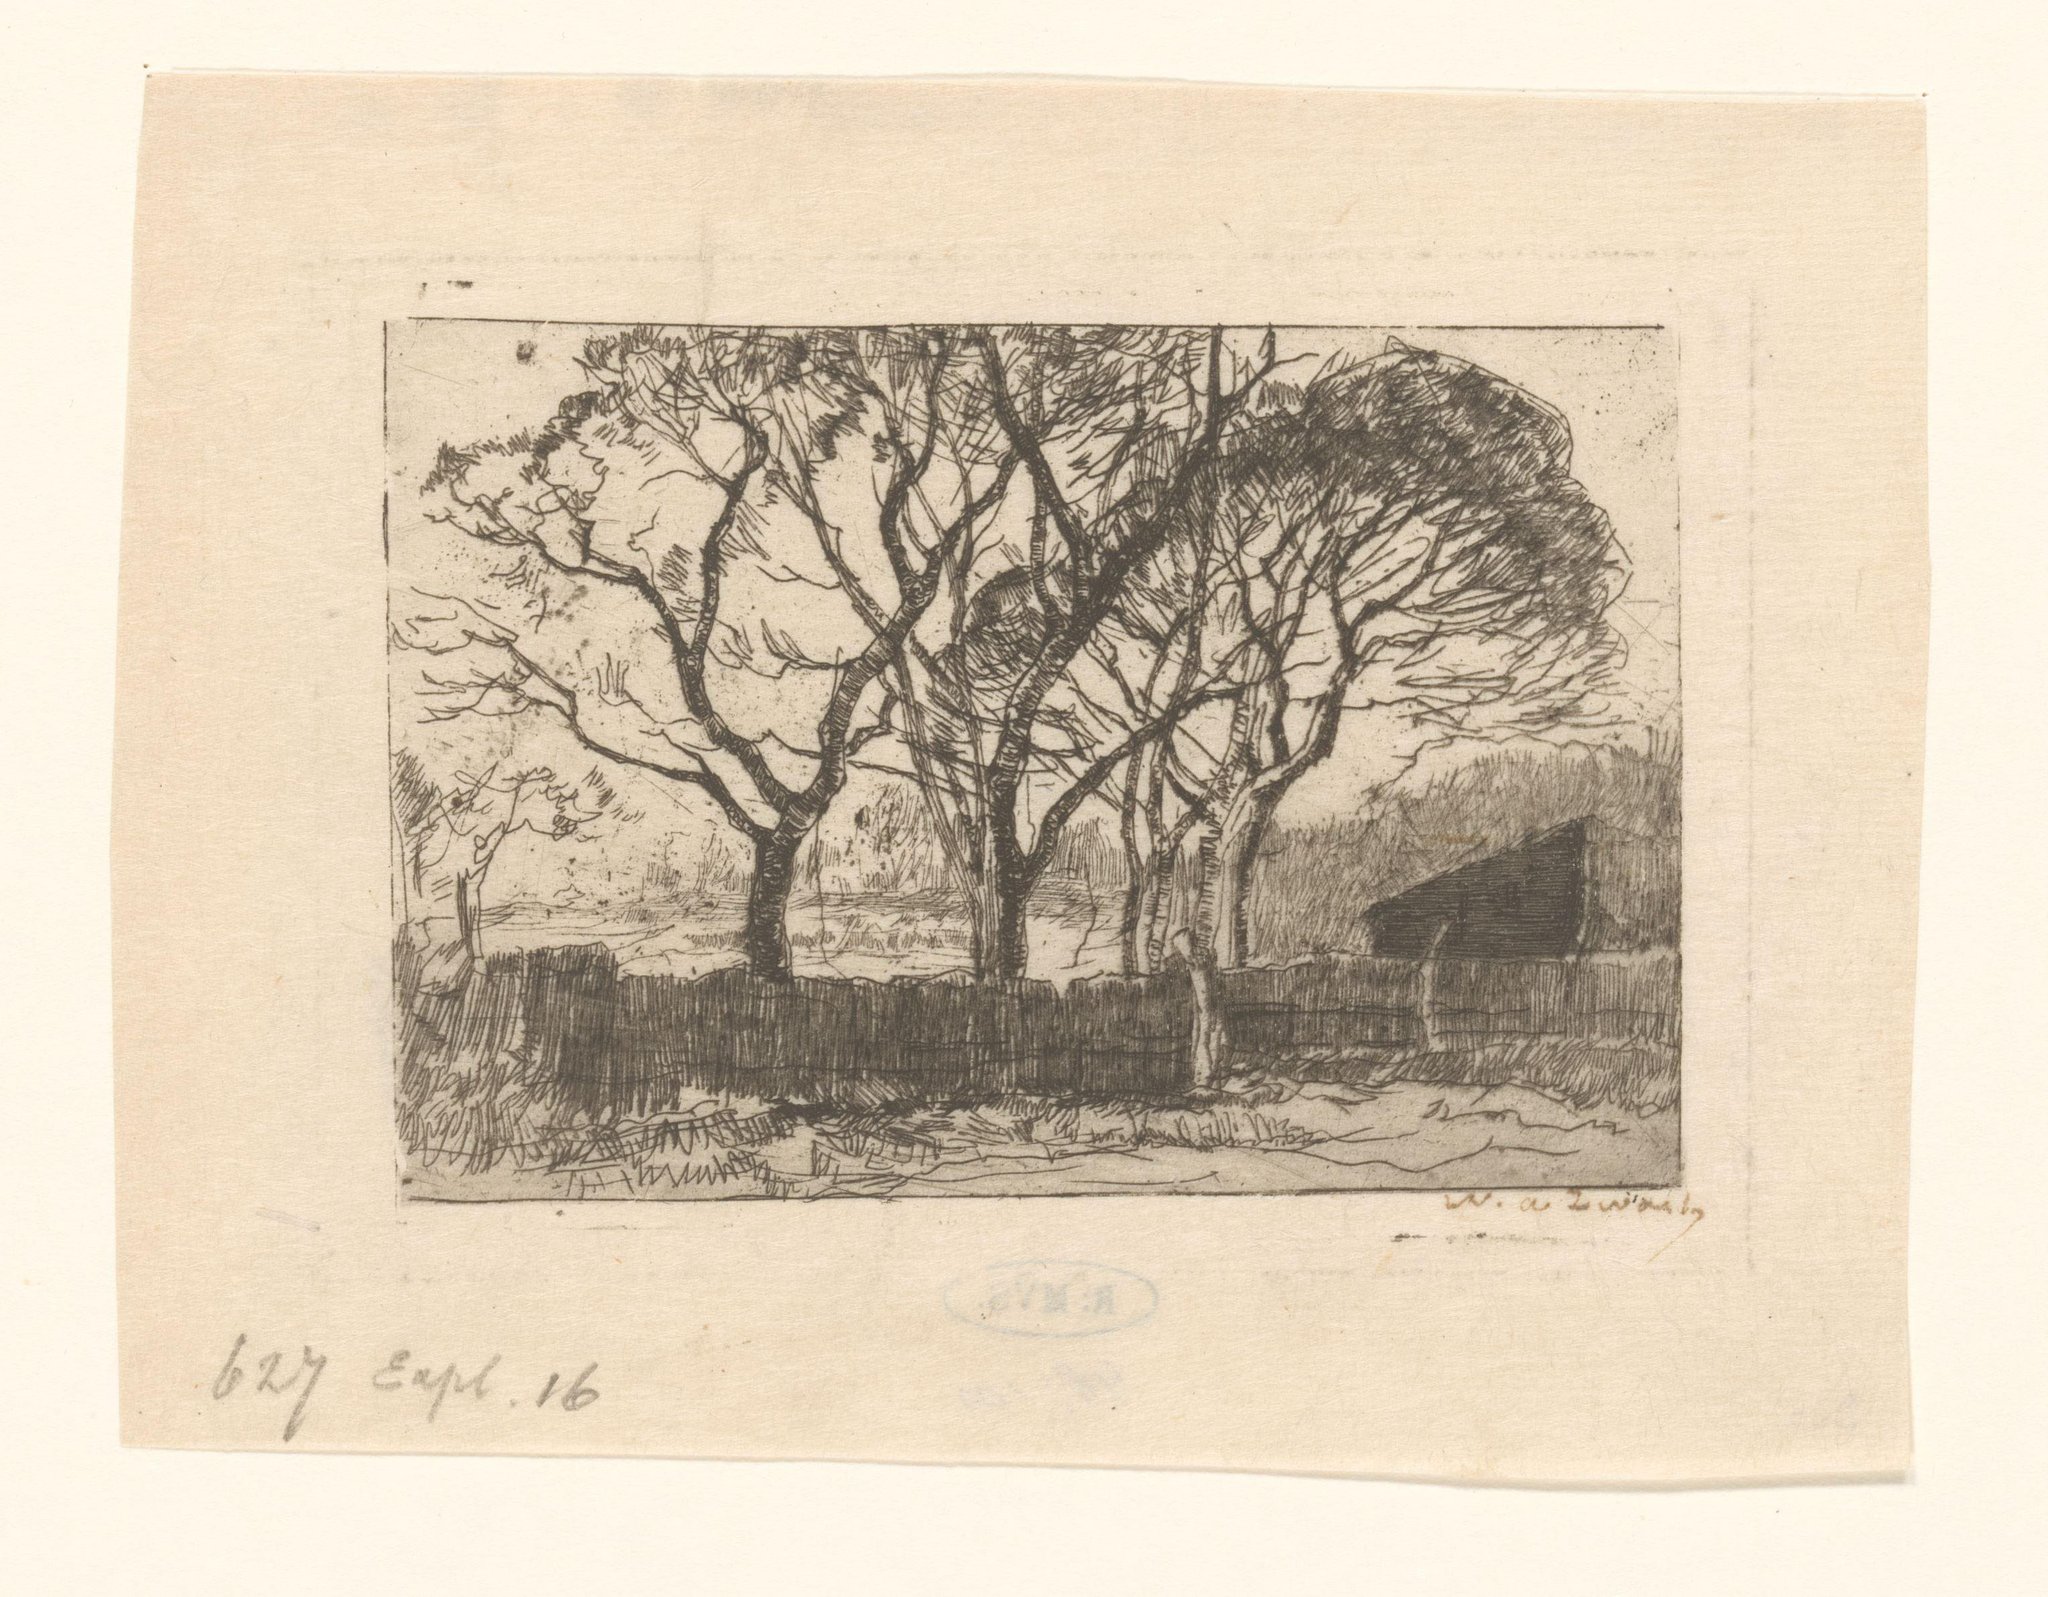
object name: print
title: Veld met bomen en een hek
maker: willem de zwart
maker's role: draughtsman, painter, print maker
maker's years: 1862-1931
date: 1889-1890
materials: paper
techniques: drypoint, etching, intaglio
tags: trees, fence, wall, paling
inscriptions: collector's mark: Lugt 2228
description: Prent verscheen in 1890 als onderdeel van de jaarlijkse uitgave van de 'Portefeuille der Nederlandsche Etsclub'.